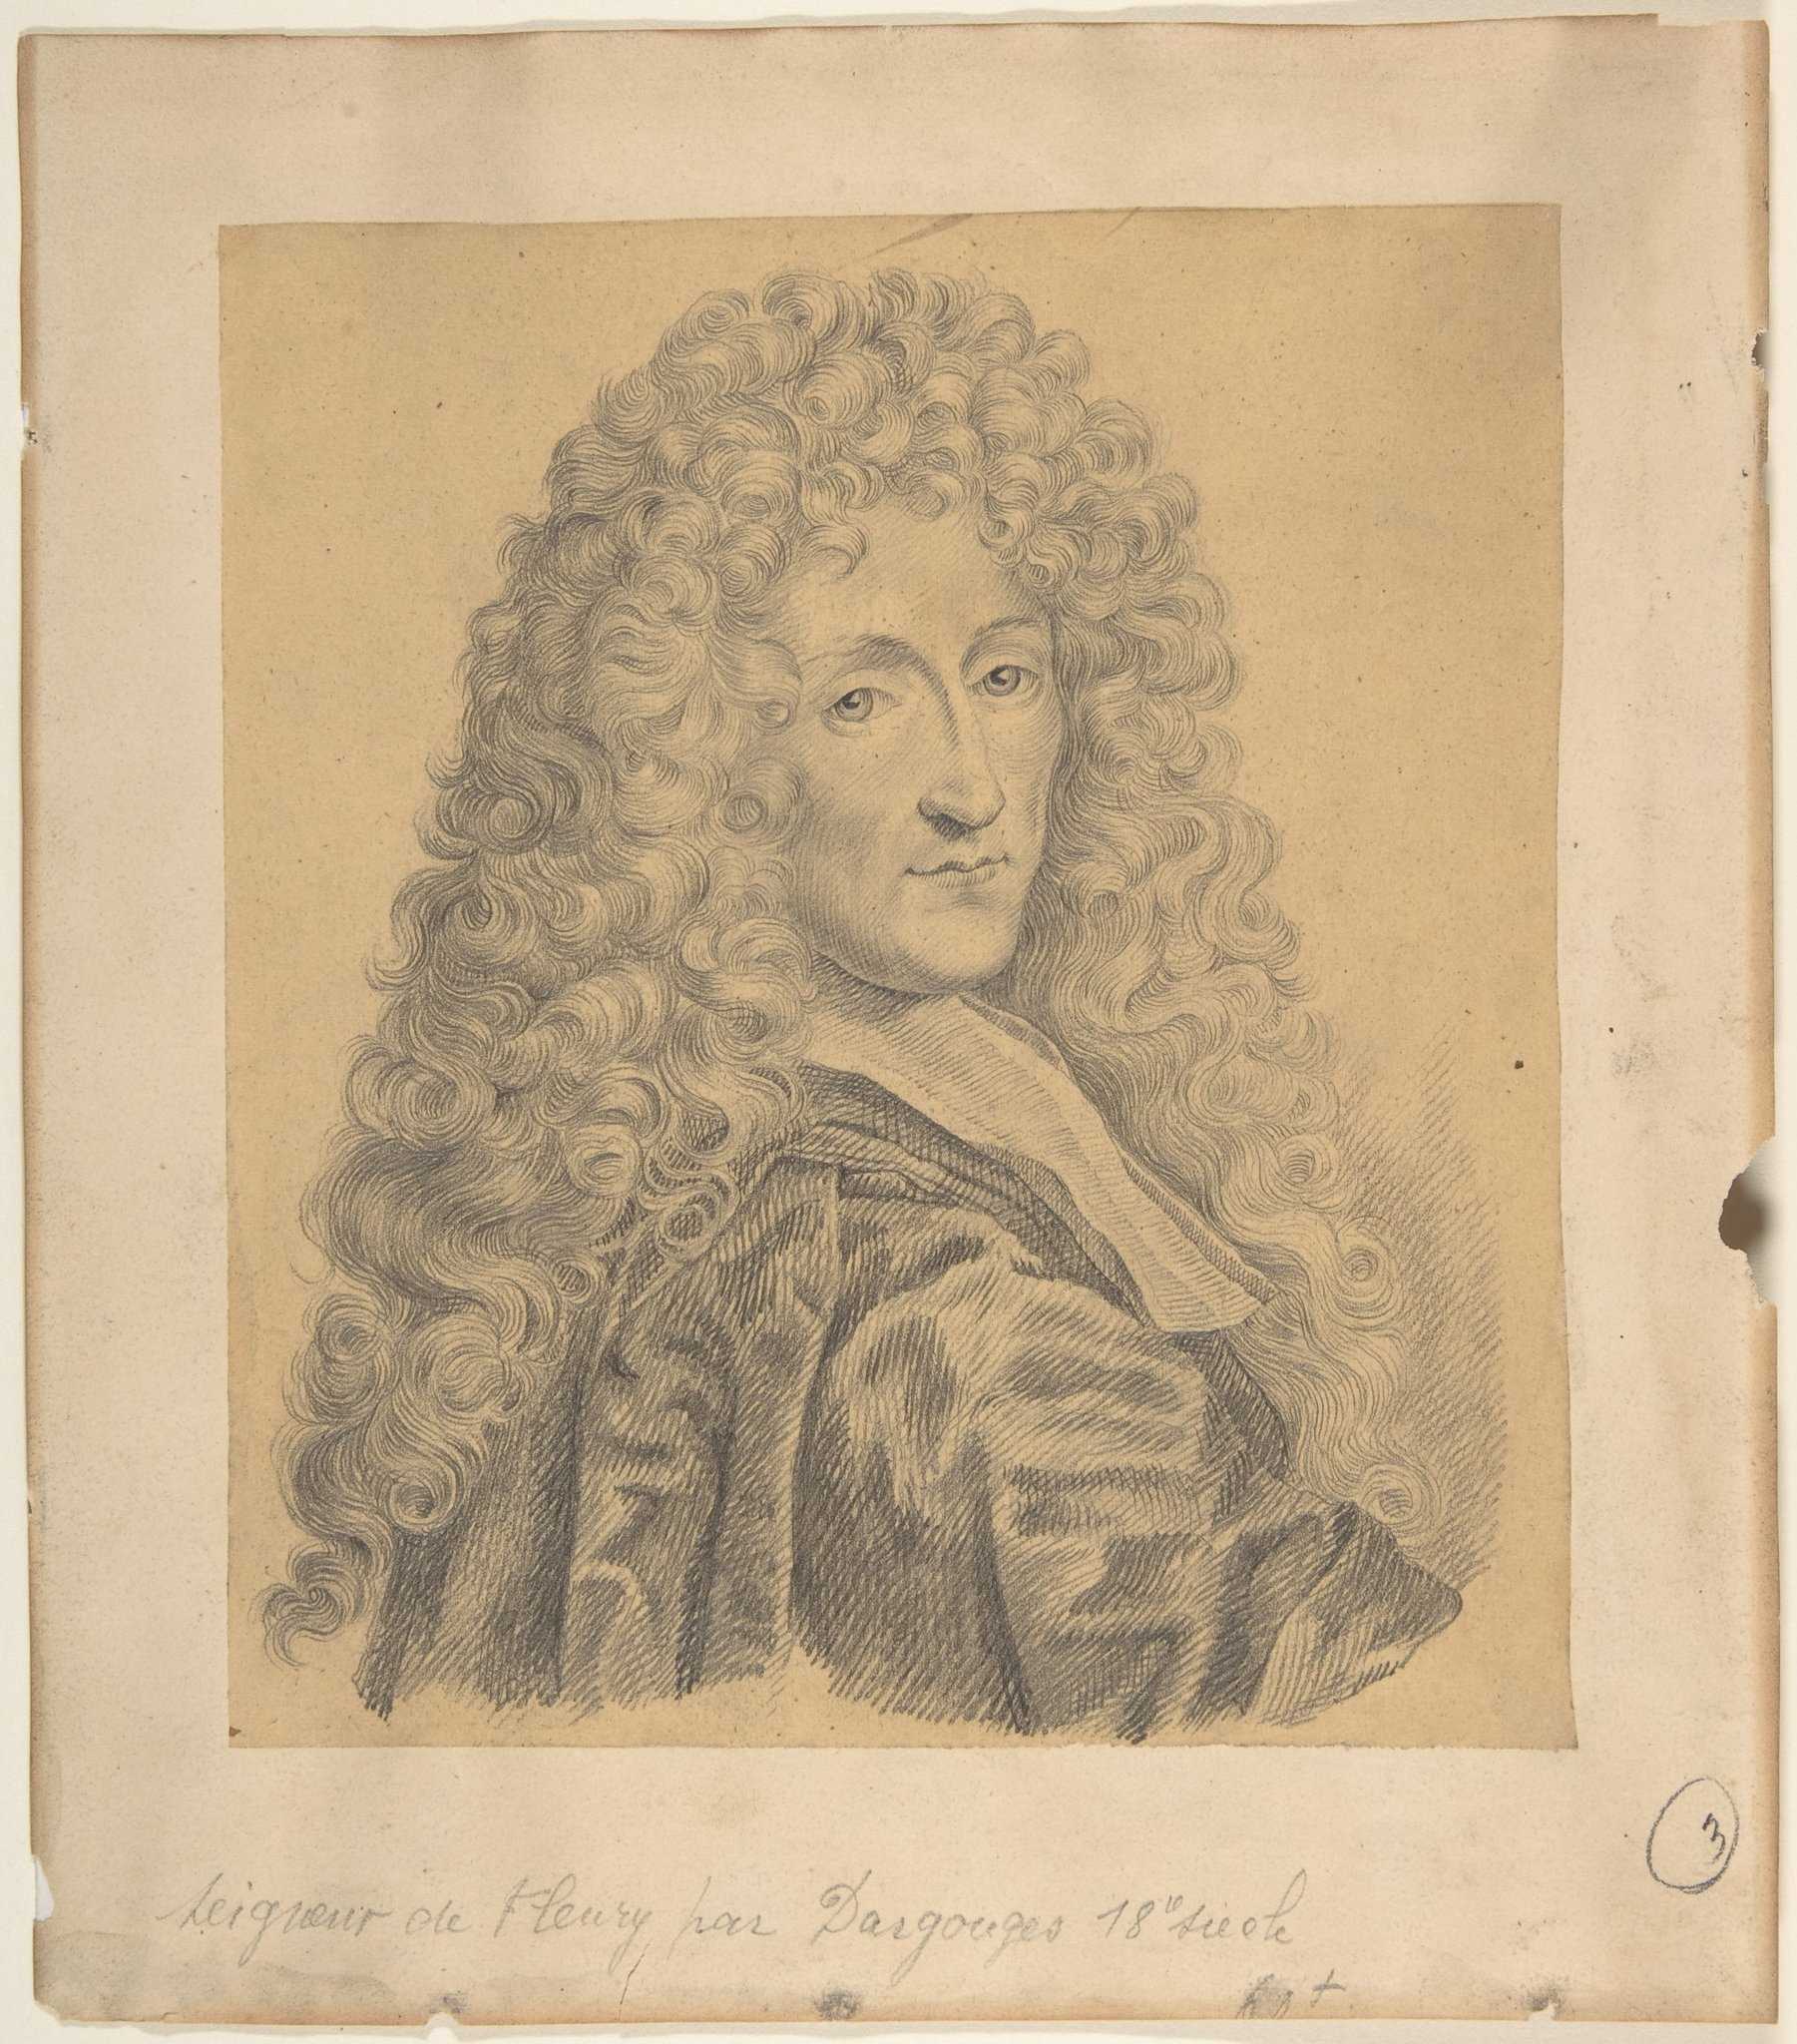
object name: drawing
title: Portrait of Fleury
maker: georges-edmond dargouge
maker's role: artist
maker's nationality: french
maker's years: 1897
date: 1897-1955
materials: graphite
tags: portraits,women